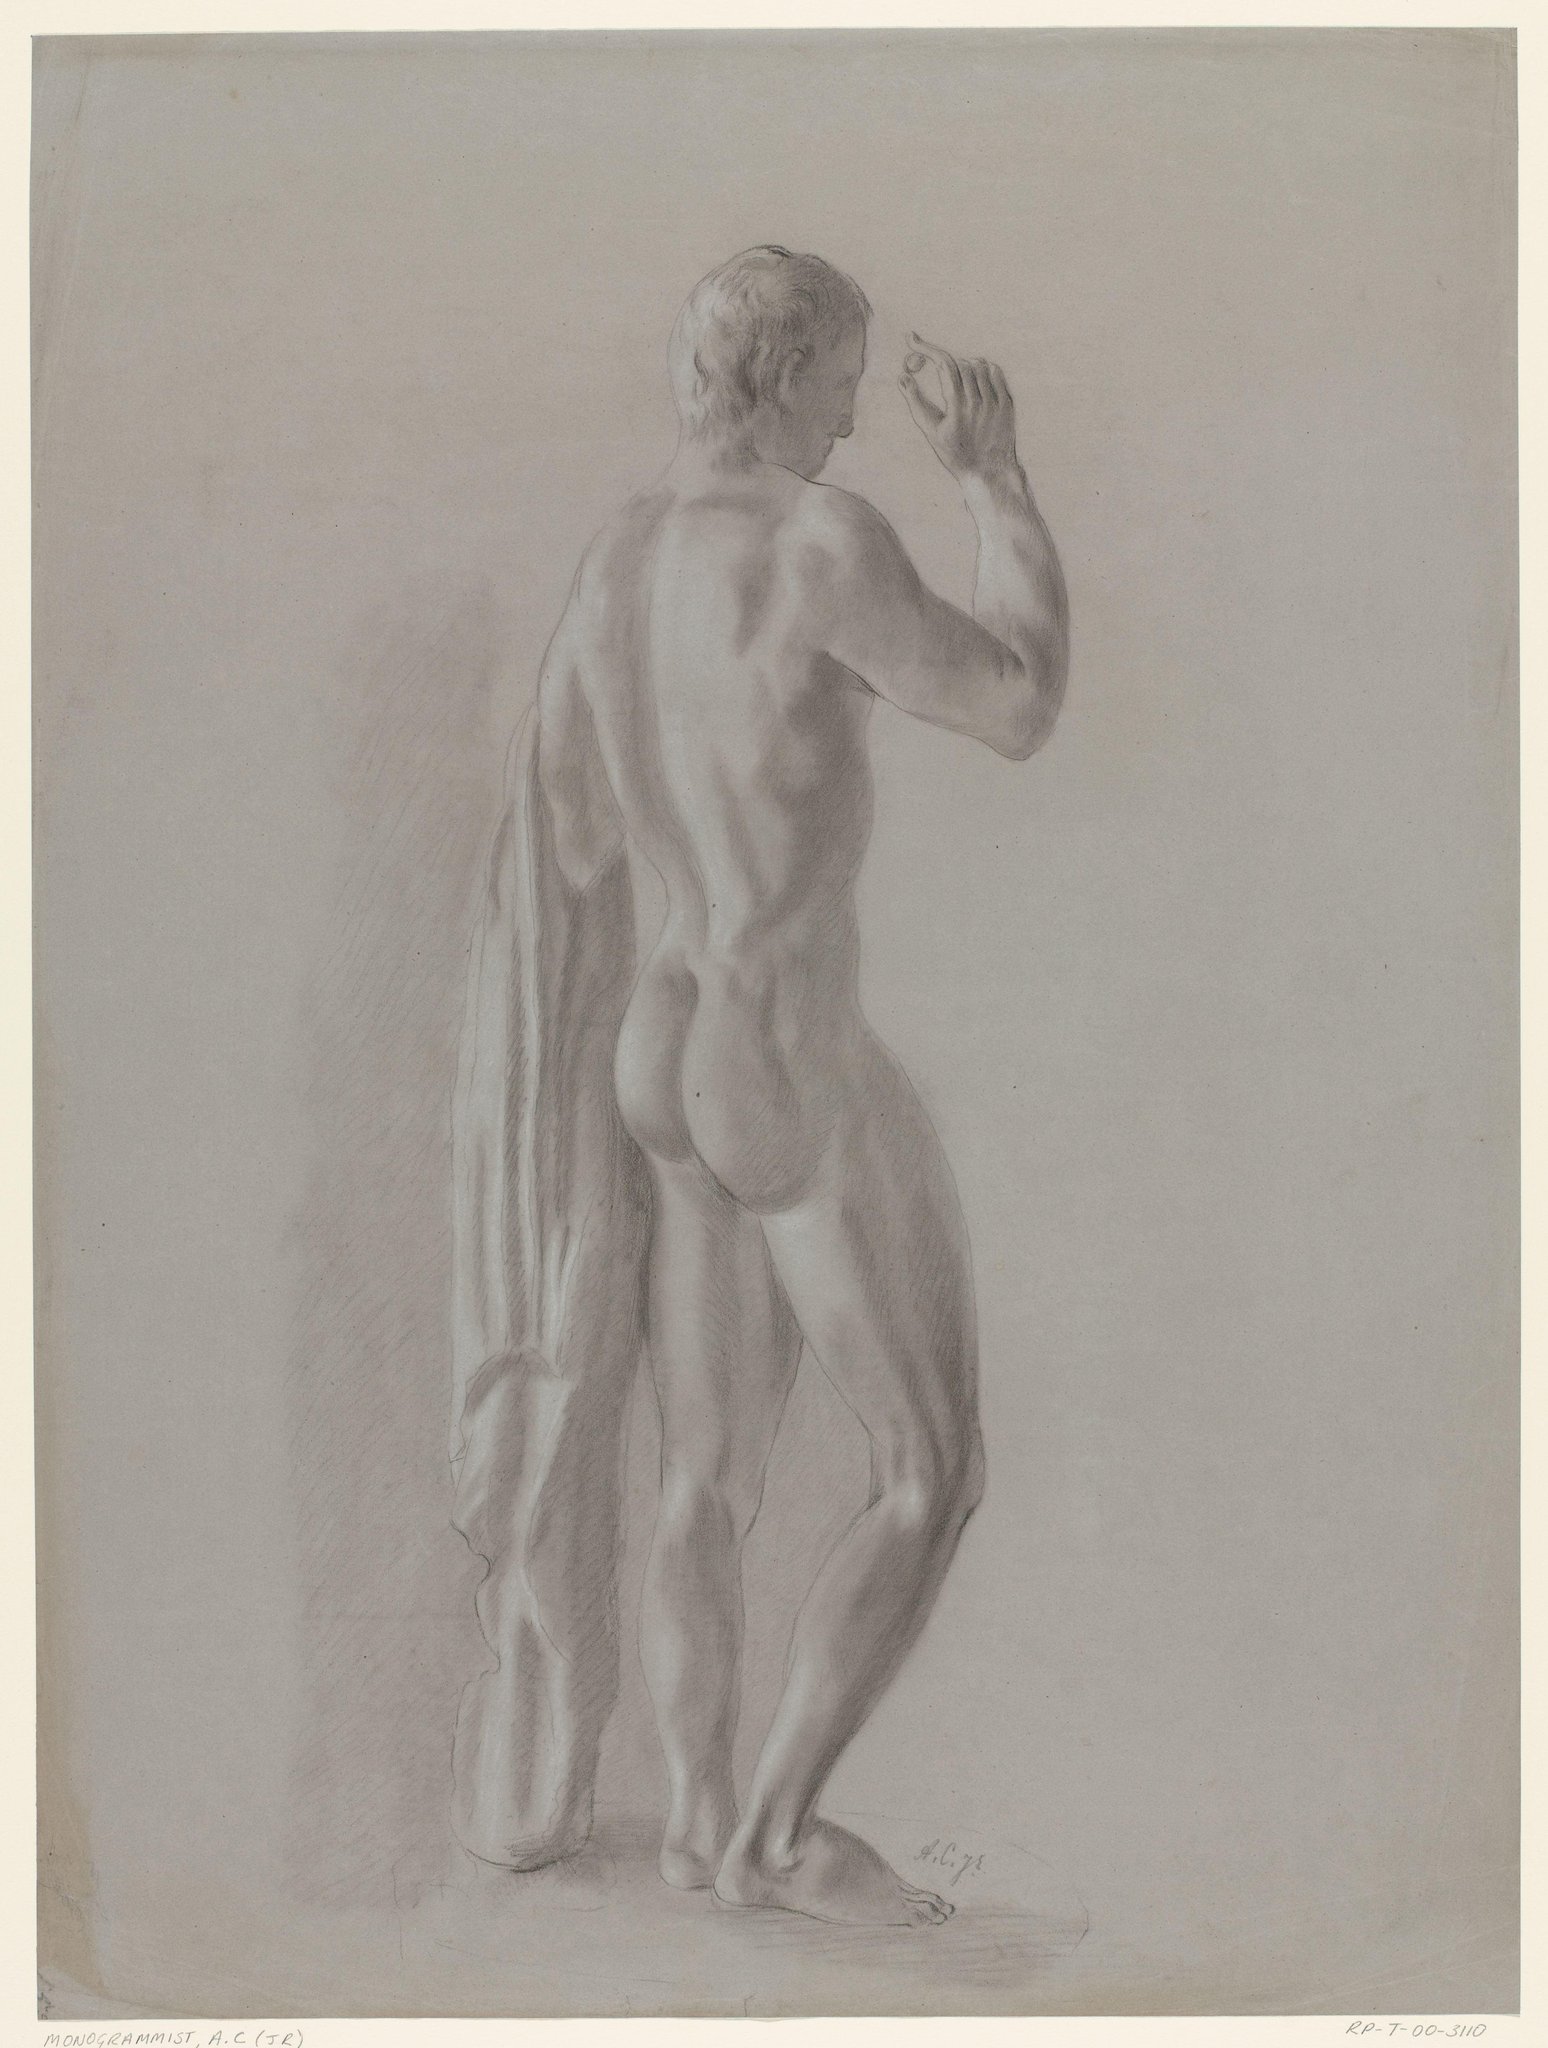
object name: drawing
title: Staand mannelijk naakt, op de rug gezien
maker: monogrammist ac (jr.)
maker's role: draughtsman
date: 1800-1900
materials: chalk, paper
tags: piece of sculpture, reproduction of a piece of sculpture (+ ceramics ~ arts)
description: Studie naar gips van een staand mannelijk naakt, op de rug gezien.